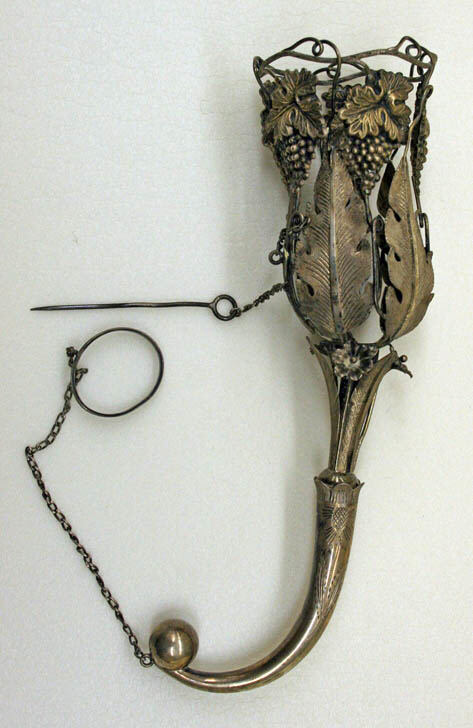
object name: bouquet holder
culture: french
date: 1801-1833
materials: silver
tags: grapes,flowers